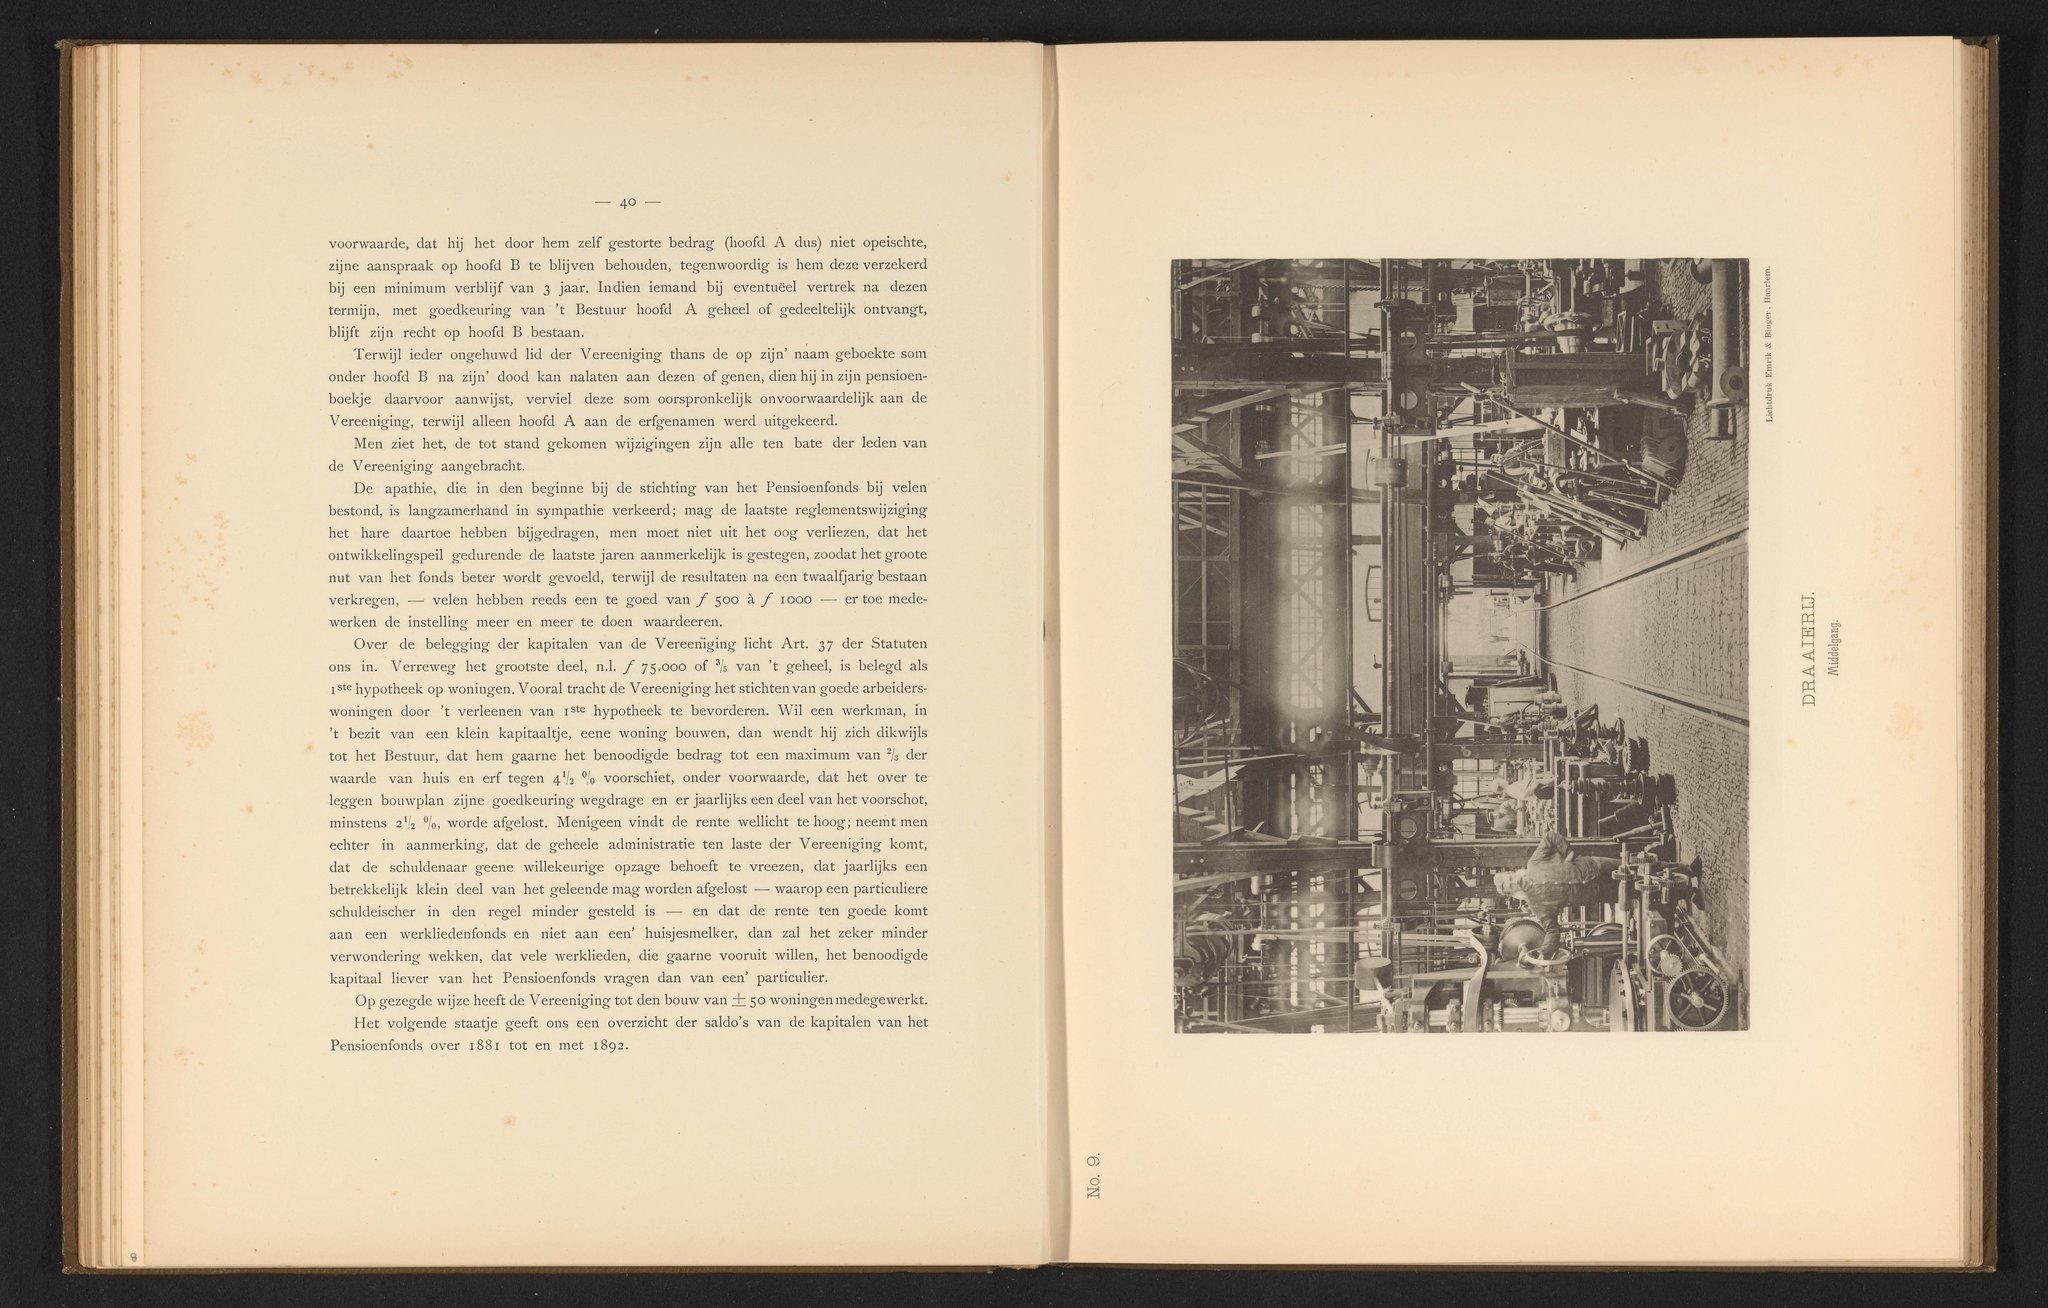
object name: page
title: Draaierij. Middelgang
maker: Anonymous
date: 1884-1894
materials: paper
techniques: photograph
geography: hengelo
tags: factory-building, factory-interior, machine shop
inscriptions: number: ‘No. 9.’